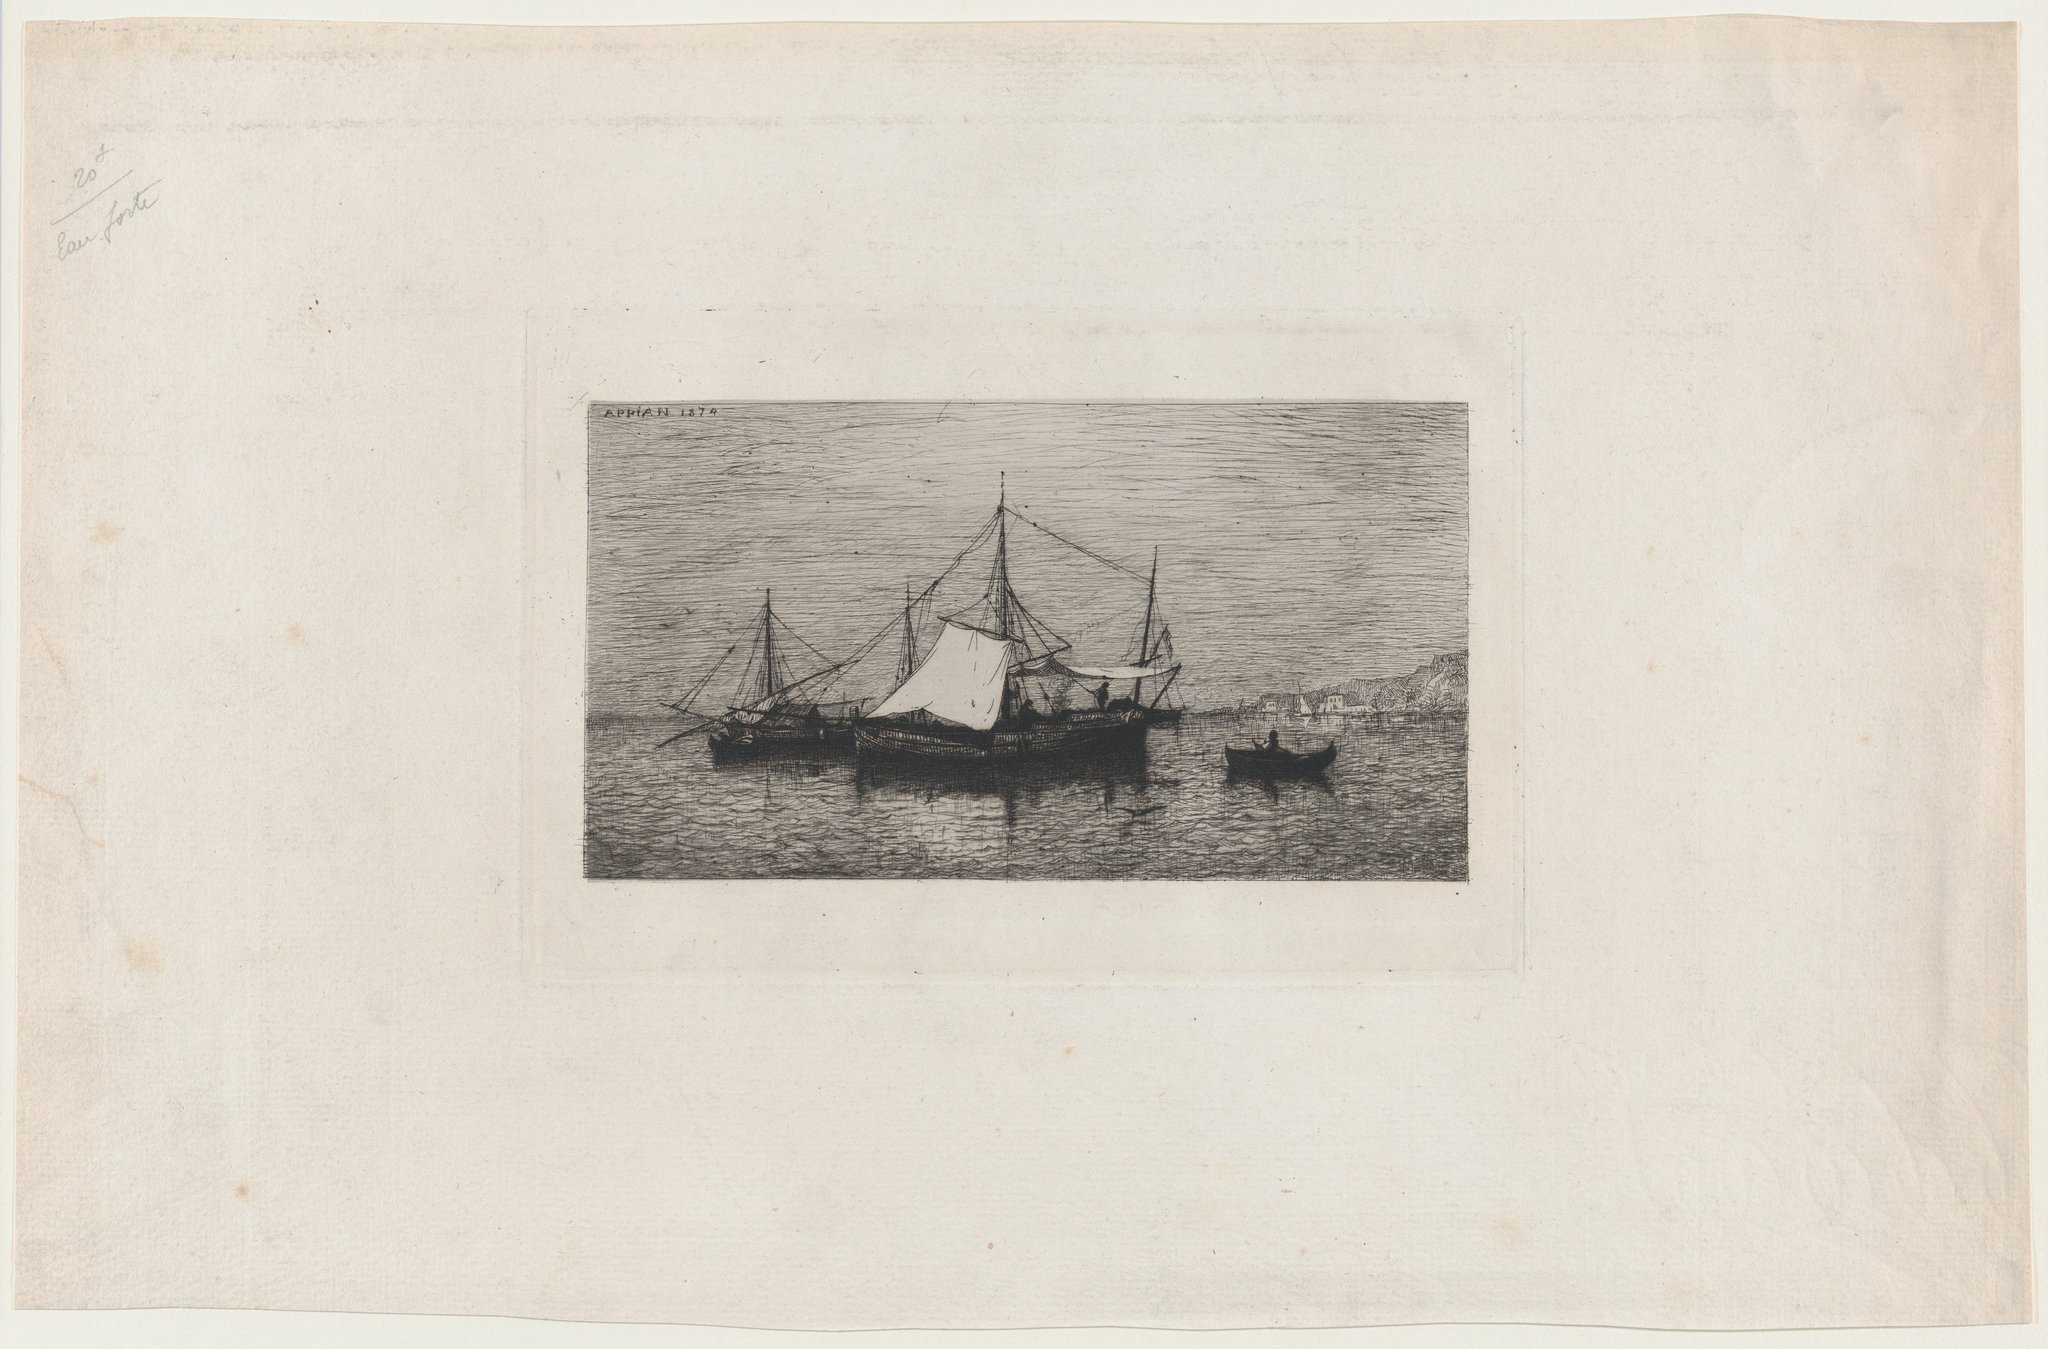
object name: print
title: Costal Navigation Boats (Coast of Italy)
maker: adolphe appian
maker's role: artist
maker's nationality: french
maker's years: 1818-1898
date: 1874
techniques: etching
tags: boats